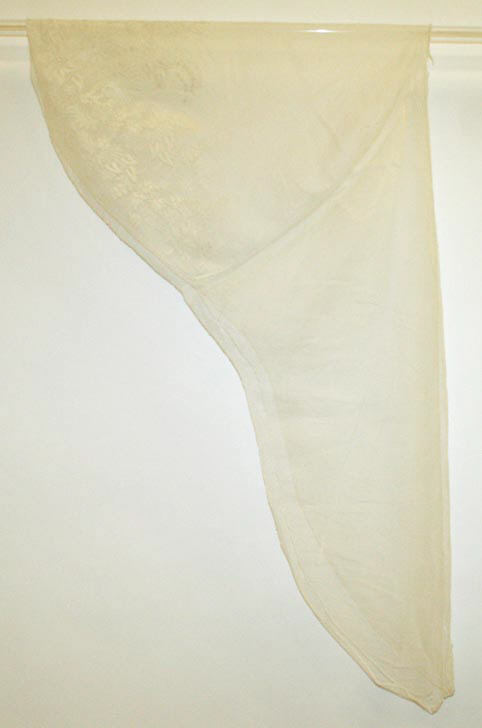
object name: scarf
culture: american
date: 1801-1833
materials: cotton, metal